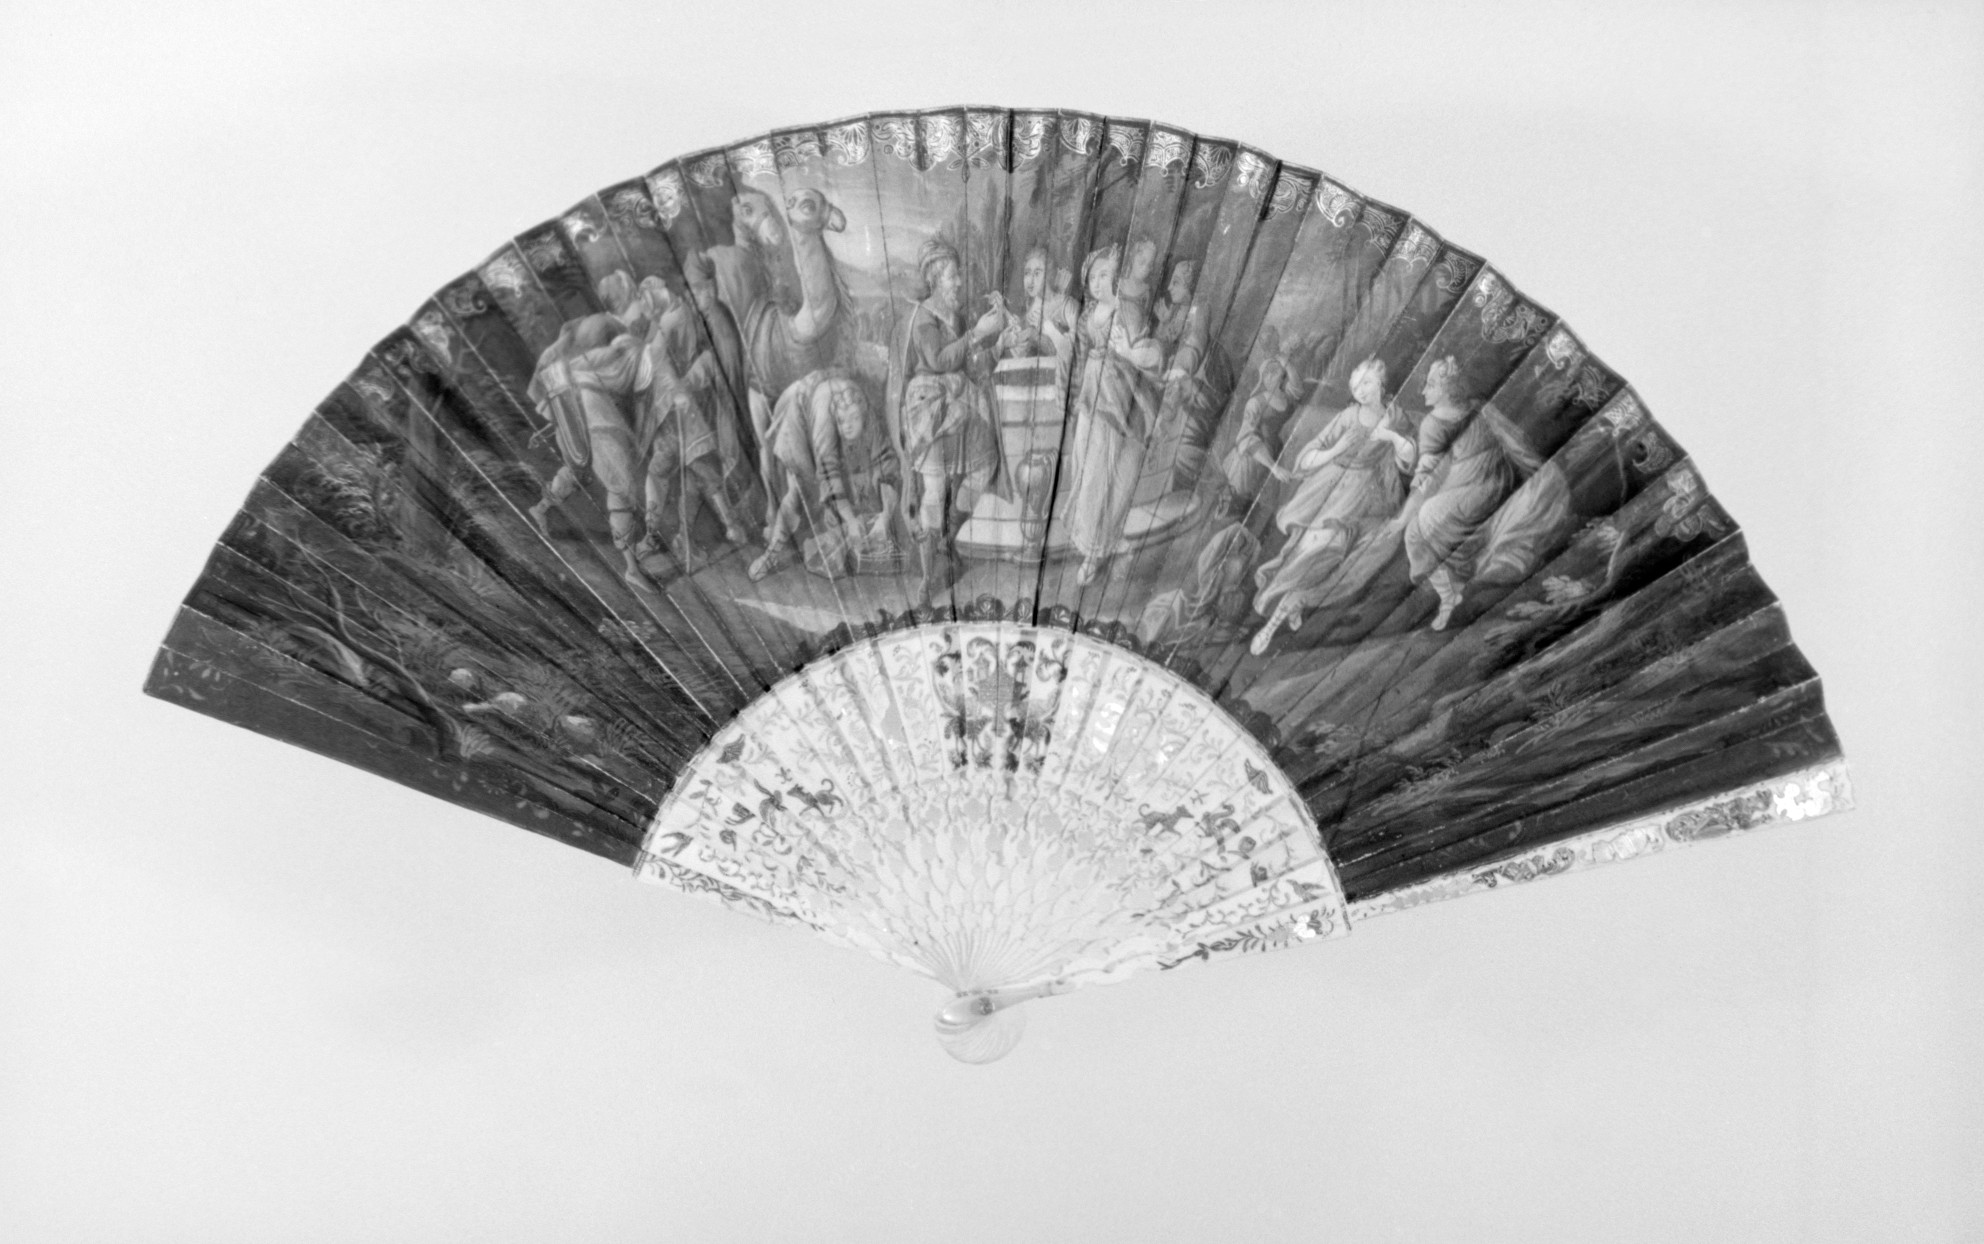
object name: fan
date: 1701-1800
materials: ivory, mother of pearl, paper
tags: men,women,camels